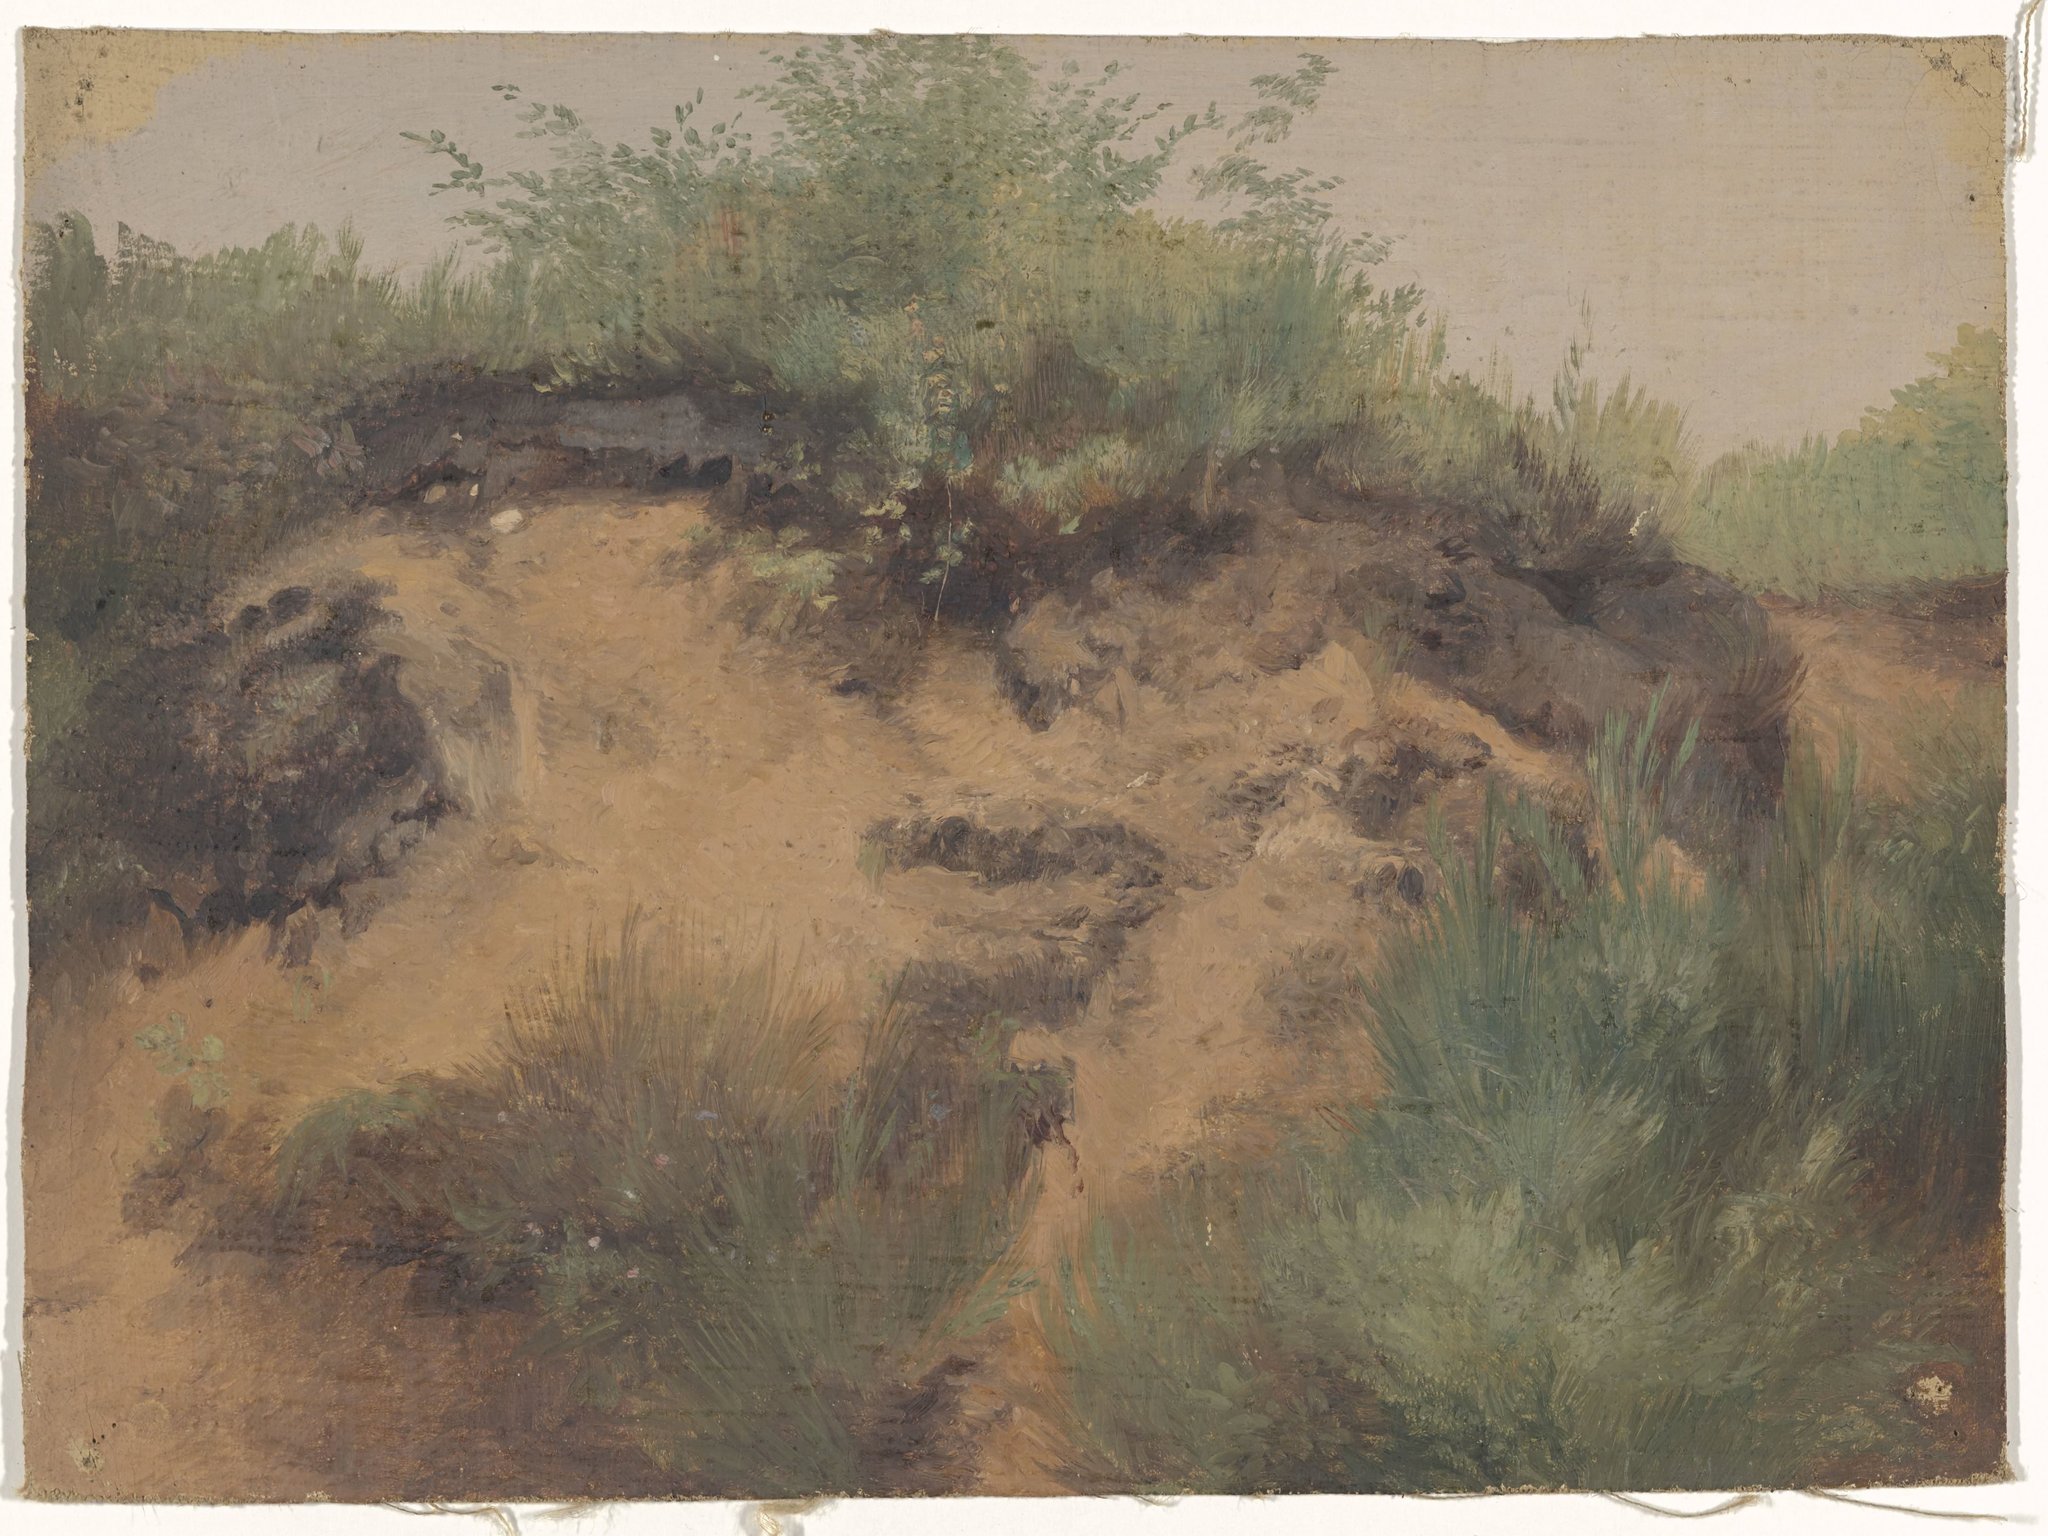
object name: oil sketch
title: Duinpan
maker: guillaume anne van der brugghen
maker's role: draughtsman, print maker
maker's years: 1812-1891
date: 1821-1891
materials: linen, oil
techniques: brush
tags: dunes (sea not visible); in the dunes